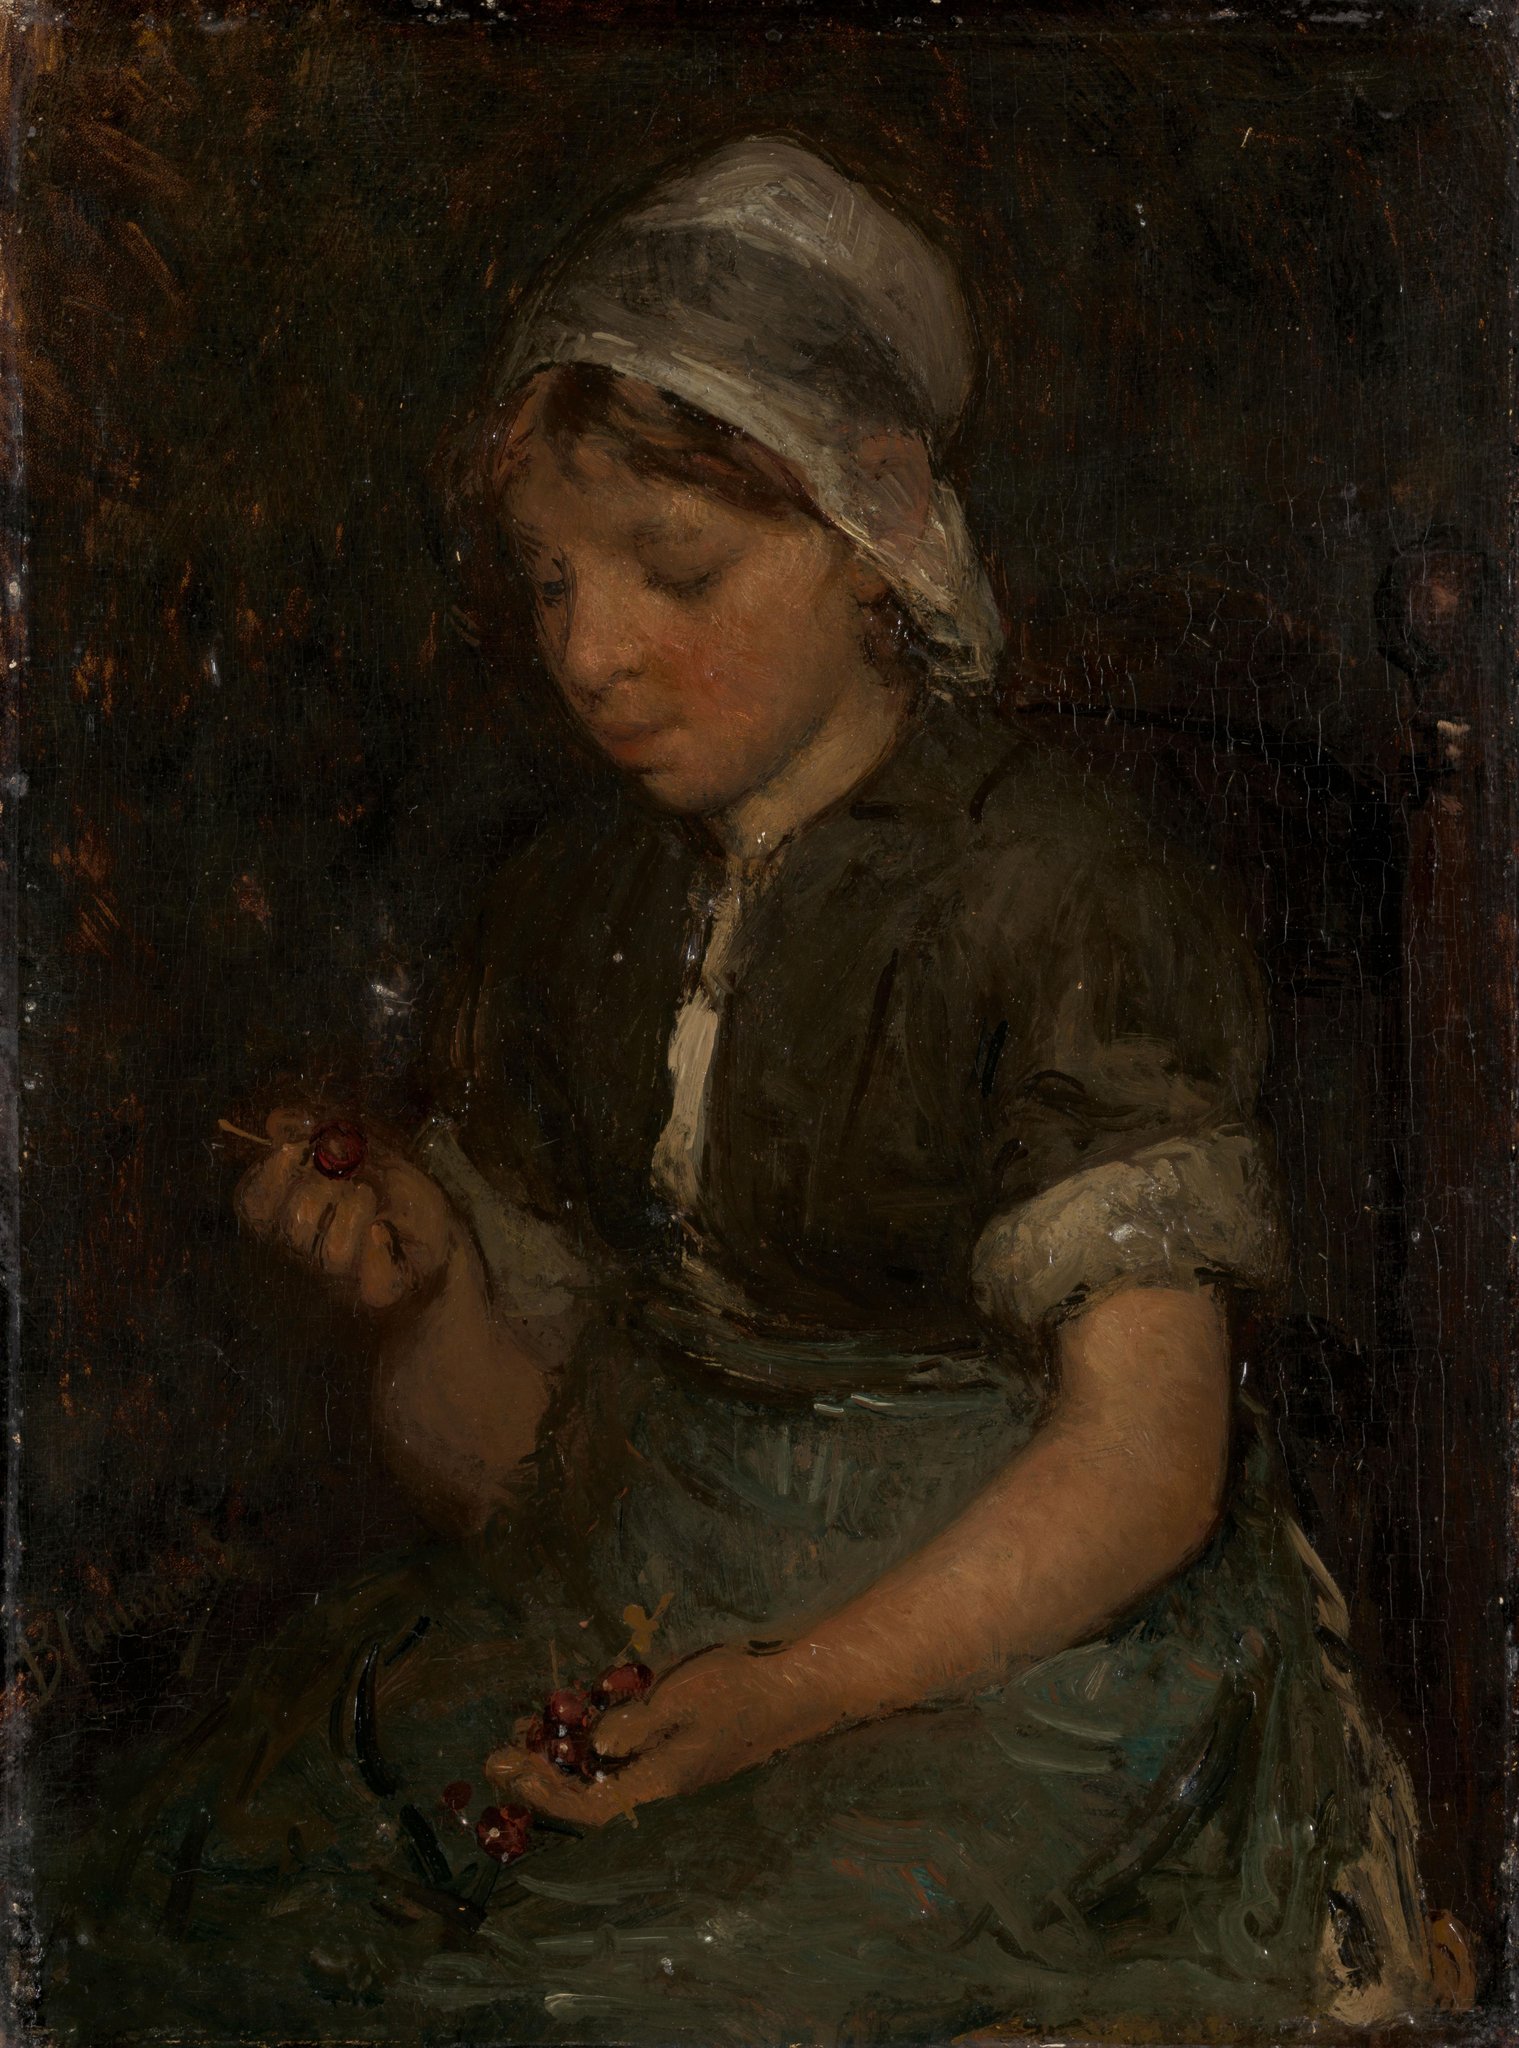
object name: painting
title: Girl with Cherries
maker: bernardus johannes blommers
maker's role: draughtsman, print maker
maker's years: 1845-1914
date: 1860-1914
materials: oil, panel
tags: adolescent, young woman, maiden, fruits: cherry